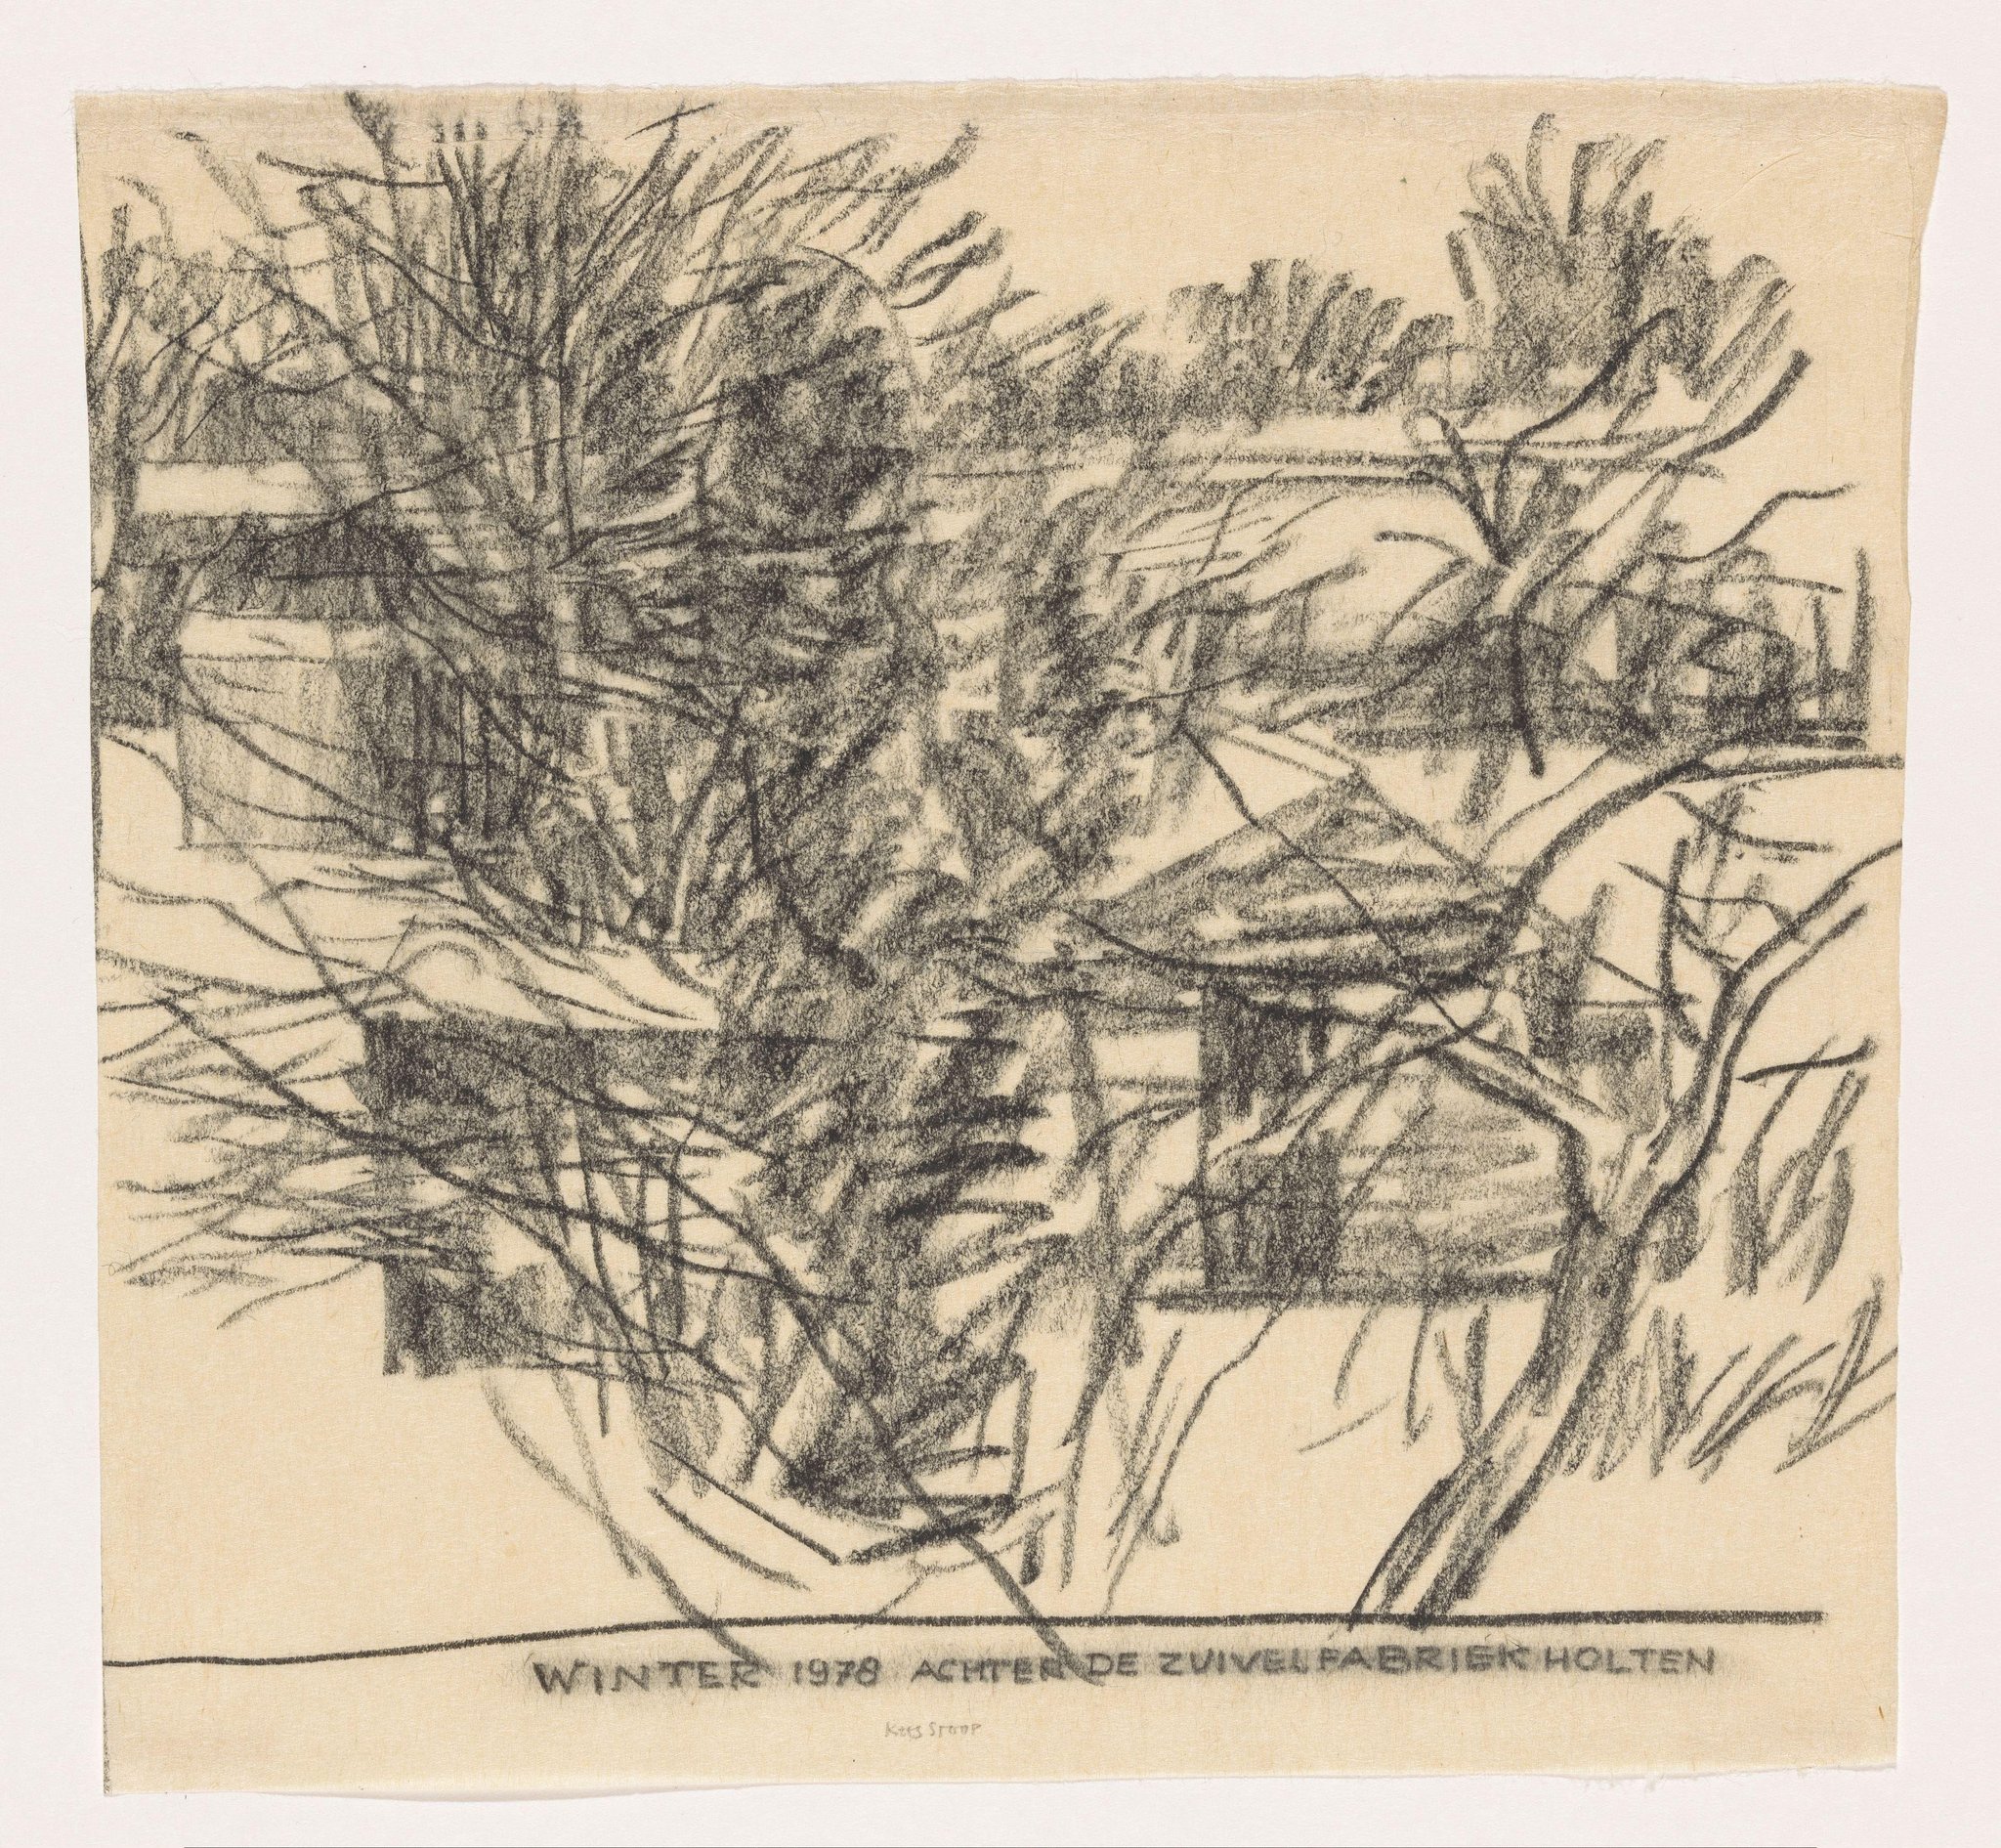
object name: drawing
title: Winter 1978 achter de zuivelfabriek Holten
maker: kees stoop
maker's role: draughtsman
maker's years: 1929-2019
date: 1978-2009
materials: charcoal, paper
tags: factories and mills in landscape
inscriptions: signature: ‘KEES STOOP’, inscription: ‘WINTER 1978 ACHTER DE ZUIVELFABRIEK HOLTEN’